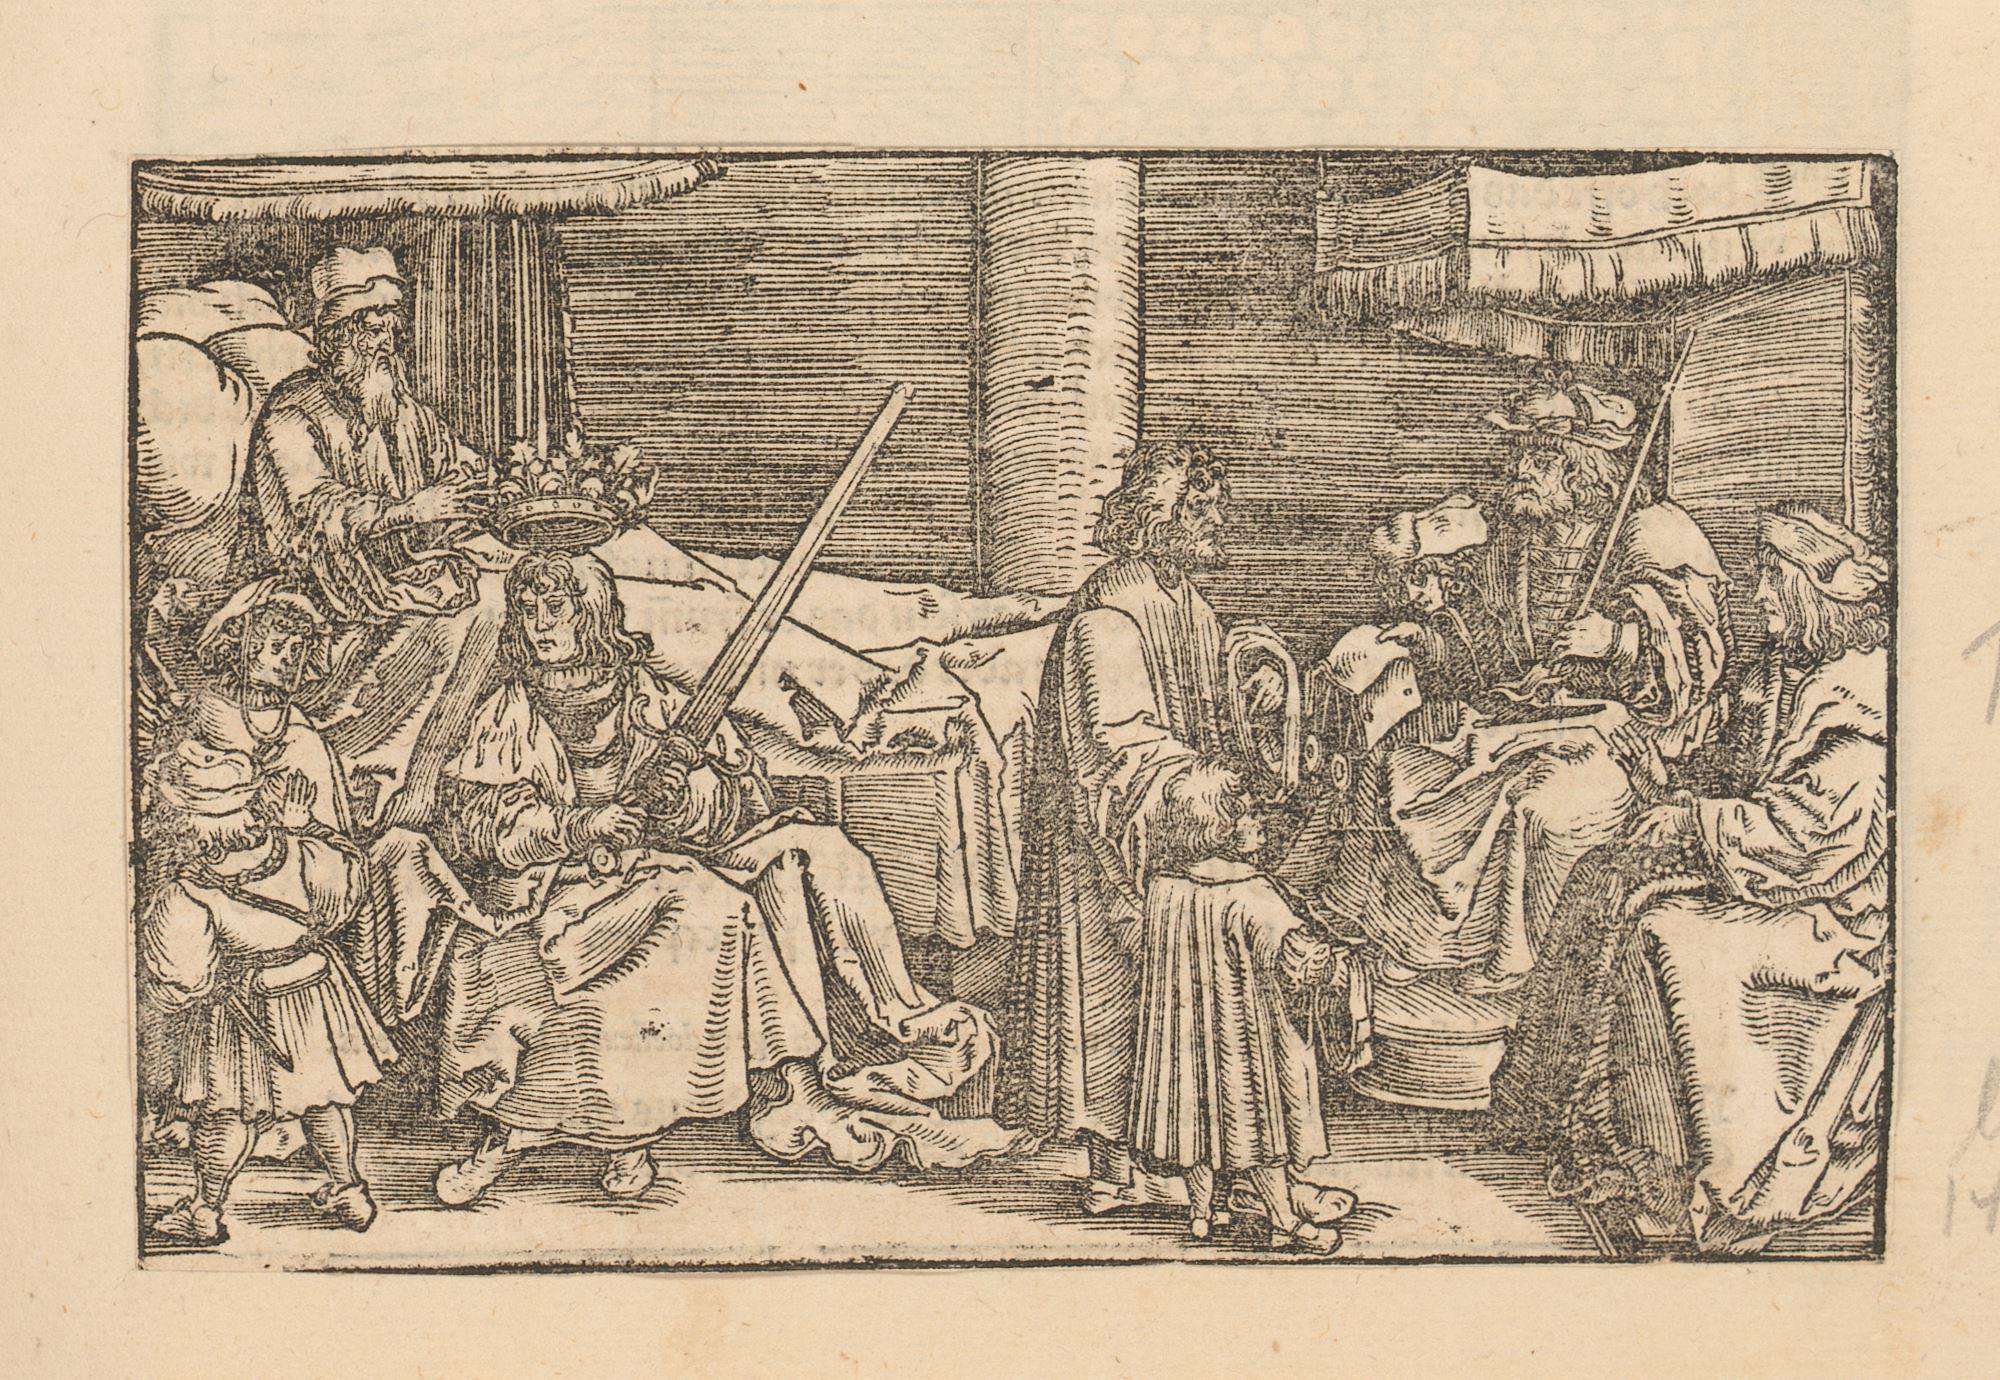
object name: book illustration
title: Zieke koning kroont zijn zoon en een rechtszaak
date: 1514-1532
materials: paper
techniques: letterpress printing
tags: court session (court of justice), family of the sovereign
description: Deze prent is gebruikt in: Petrarca, Francesco. Von der Artzney bayder Glück, des guten und widerwertigen: unnd weß sich ain yeder inn Gelück und Unglück halten sol (...). Augsburg: Heinrich Steiner, 1532. Deze uitgave is ook bekend onder de titel 'Trostspiegel in Glück und Unglück'. Deze prent is ook gebruikt in: Cicero, Marcus Tulius. Officia M.T.C. Ein Buch so Marcus Tullius Cicero der Römer zu seynem (...). [Vertaald uit het Latijn door] Johann von Schwarzenberg. Augsburg: Heinrich Steiner, 1531.